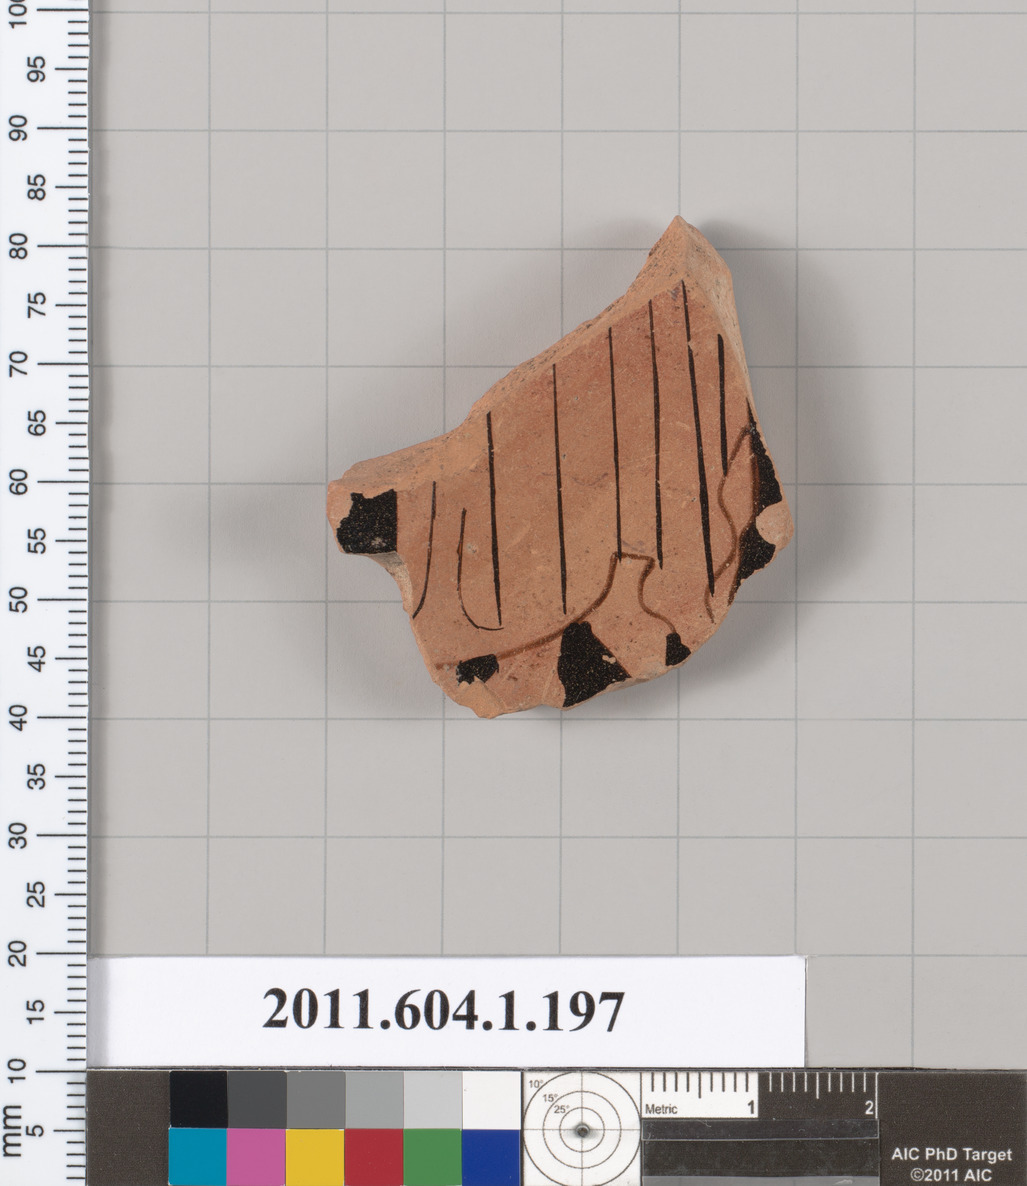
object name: kylix fragment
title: Terracotta fragment of a kylix (drinking cup)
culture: greek, attic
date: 475-451 BCE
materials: terracotta